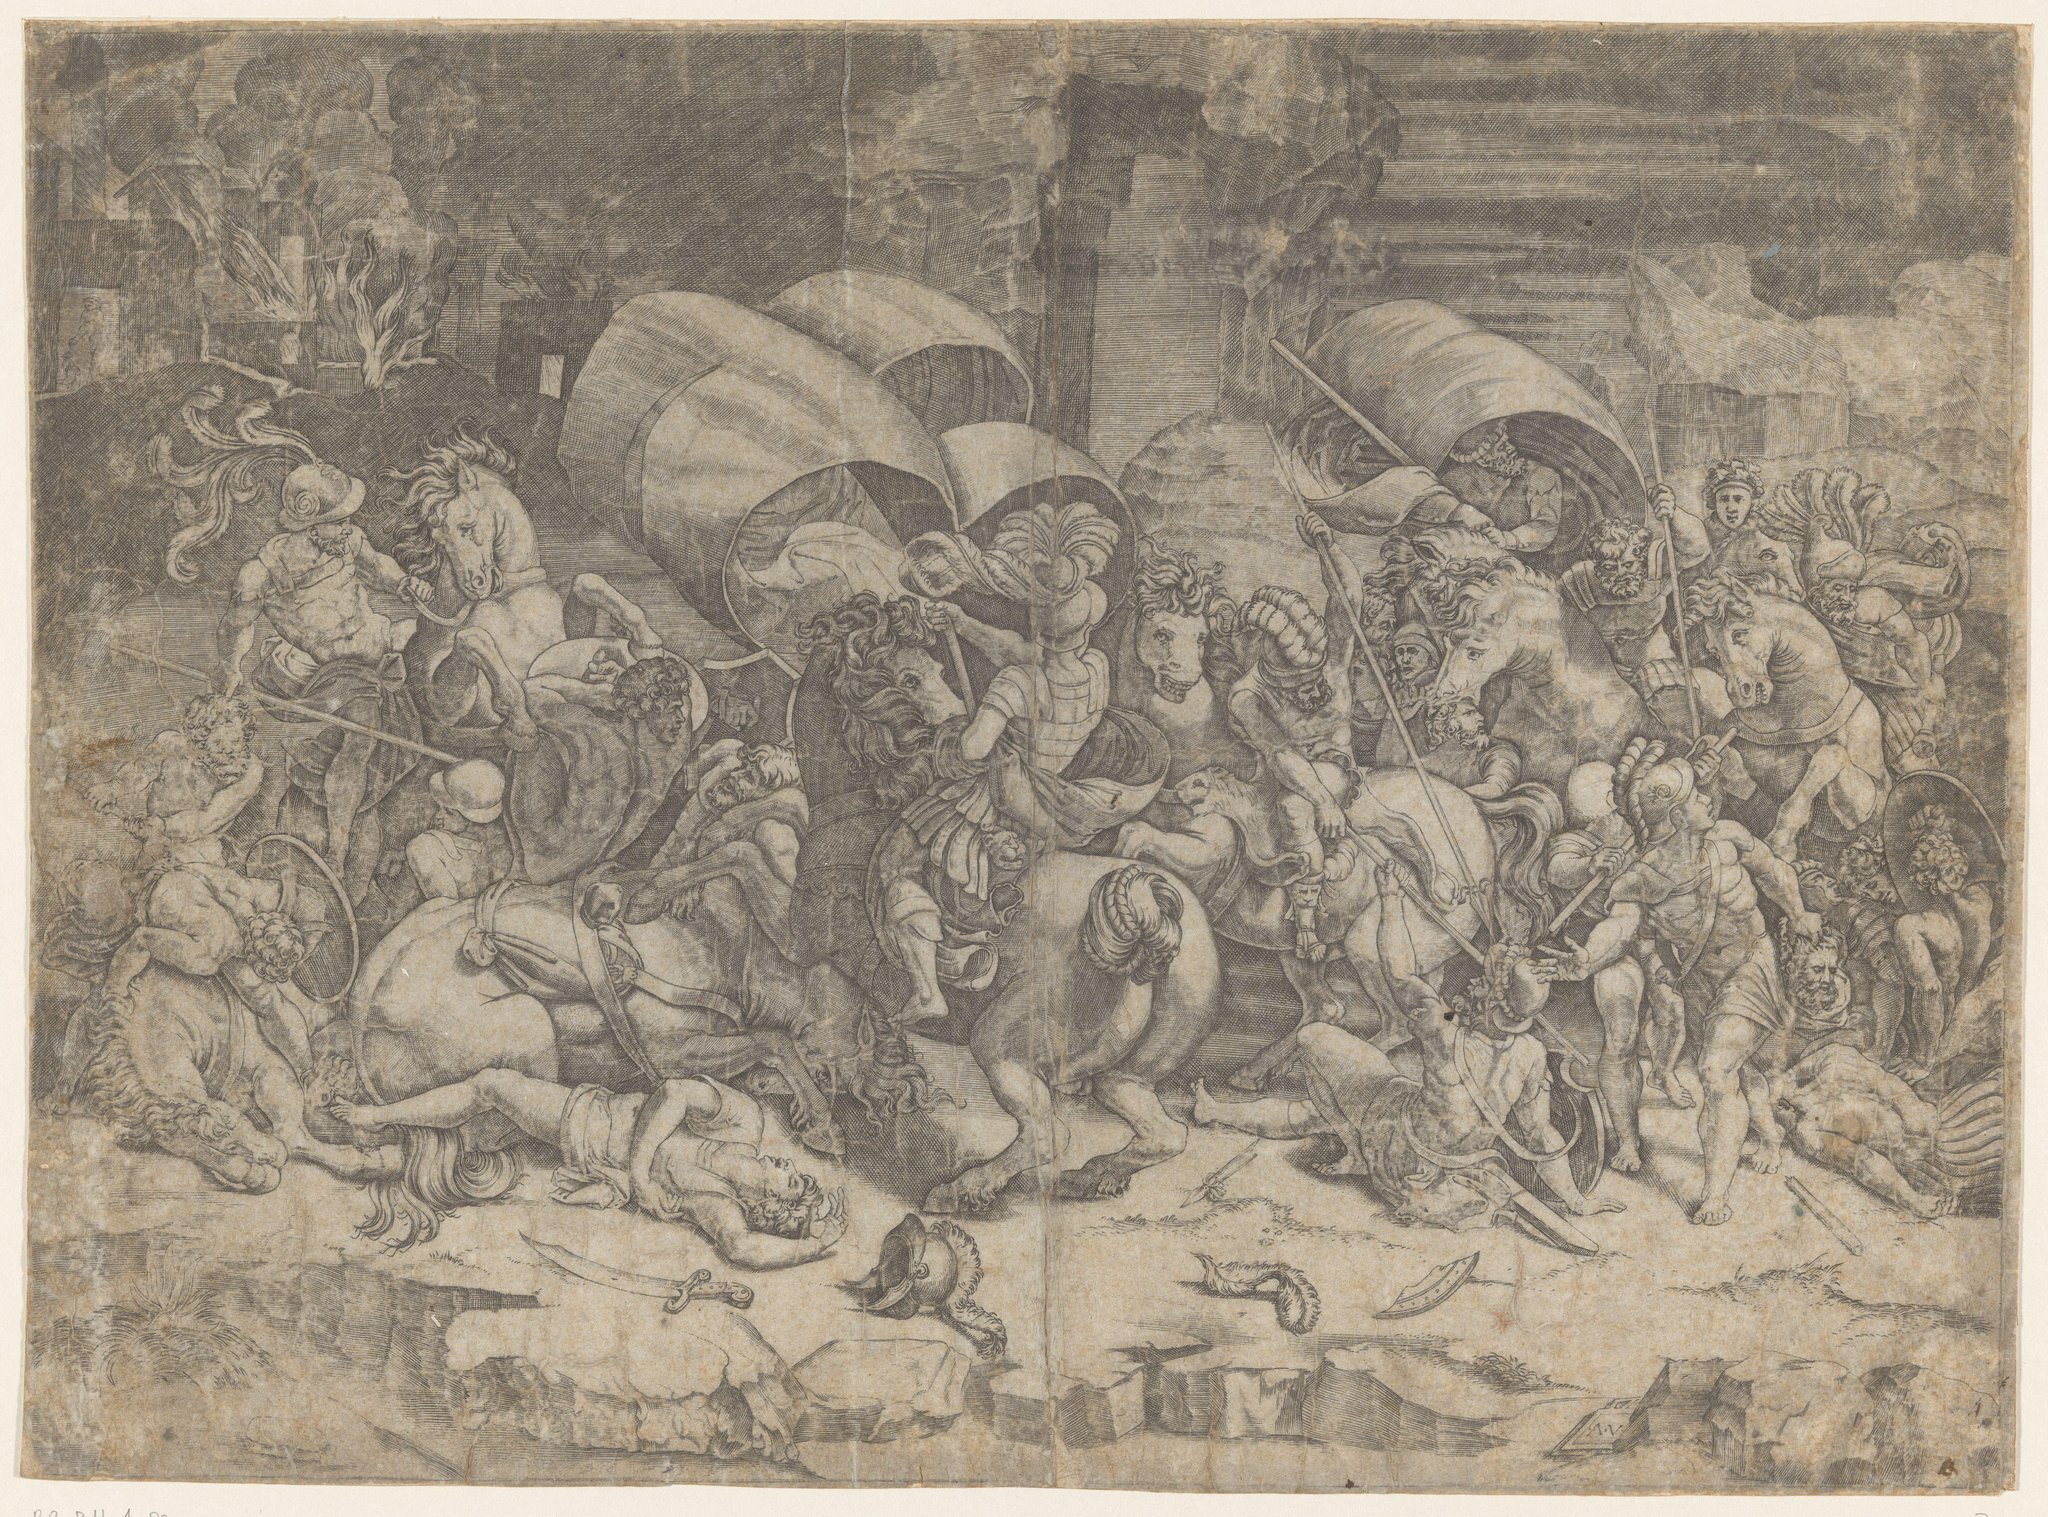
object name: print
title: Veldslag tussen Romeinen en Carthagers, ca. 218-201 v.Chr.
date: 1500-1536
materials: paper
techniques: engraving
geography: italy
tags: rome, politician, battle, hacking and thrusting weapons: sword, (story of) p. cornelius scipio africanus minor (p. cornelius scipio aemilianus), setting on fire (of conquered city)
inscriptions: collector's mark: Lugt 11, number: ‘A 83’, collector's mark: Lugt 10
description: Een gevecht tussen de Romeinen, geleid door Scipio Africanus, en de Carthagers. Soldaten te voet en te paard in gevecht met elkaar. Links op de achtergrond een stad in brand. Links op de voorgrond ligt de hartsvanger (type jachtzwaard) waar de doorgaans gebruikte titel van de prent naar verwijst. Waarschijnlijk tijdens de Tweede Punische Oorlog (218 v.Chr. - 201 v.Chr.).